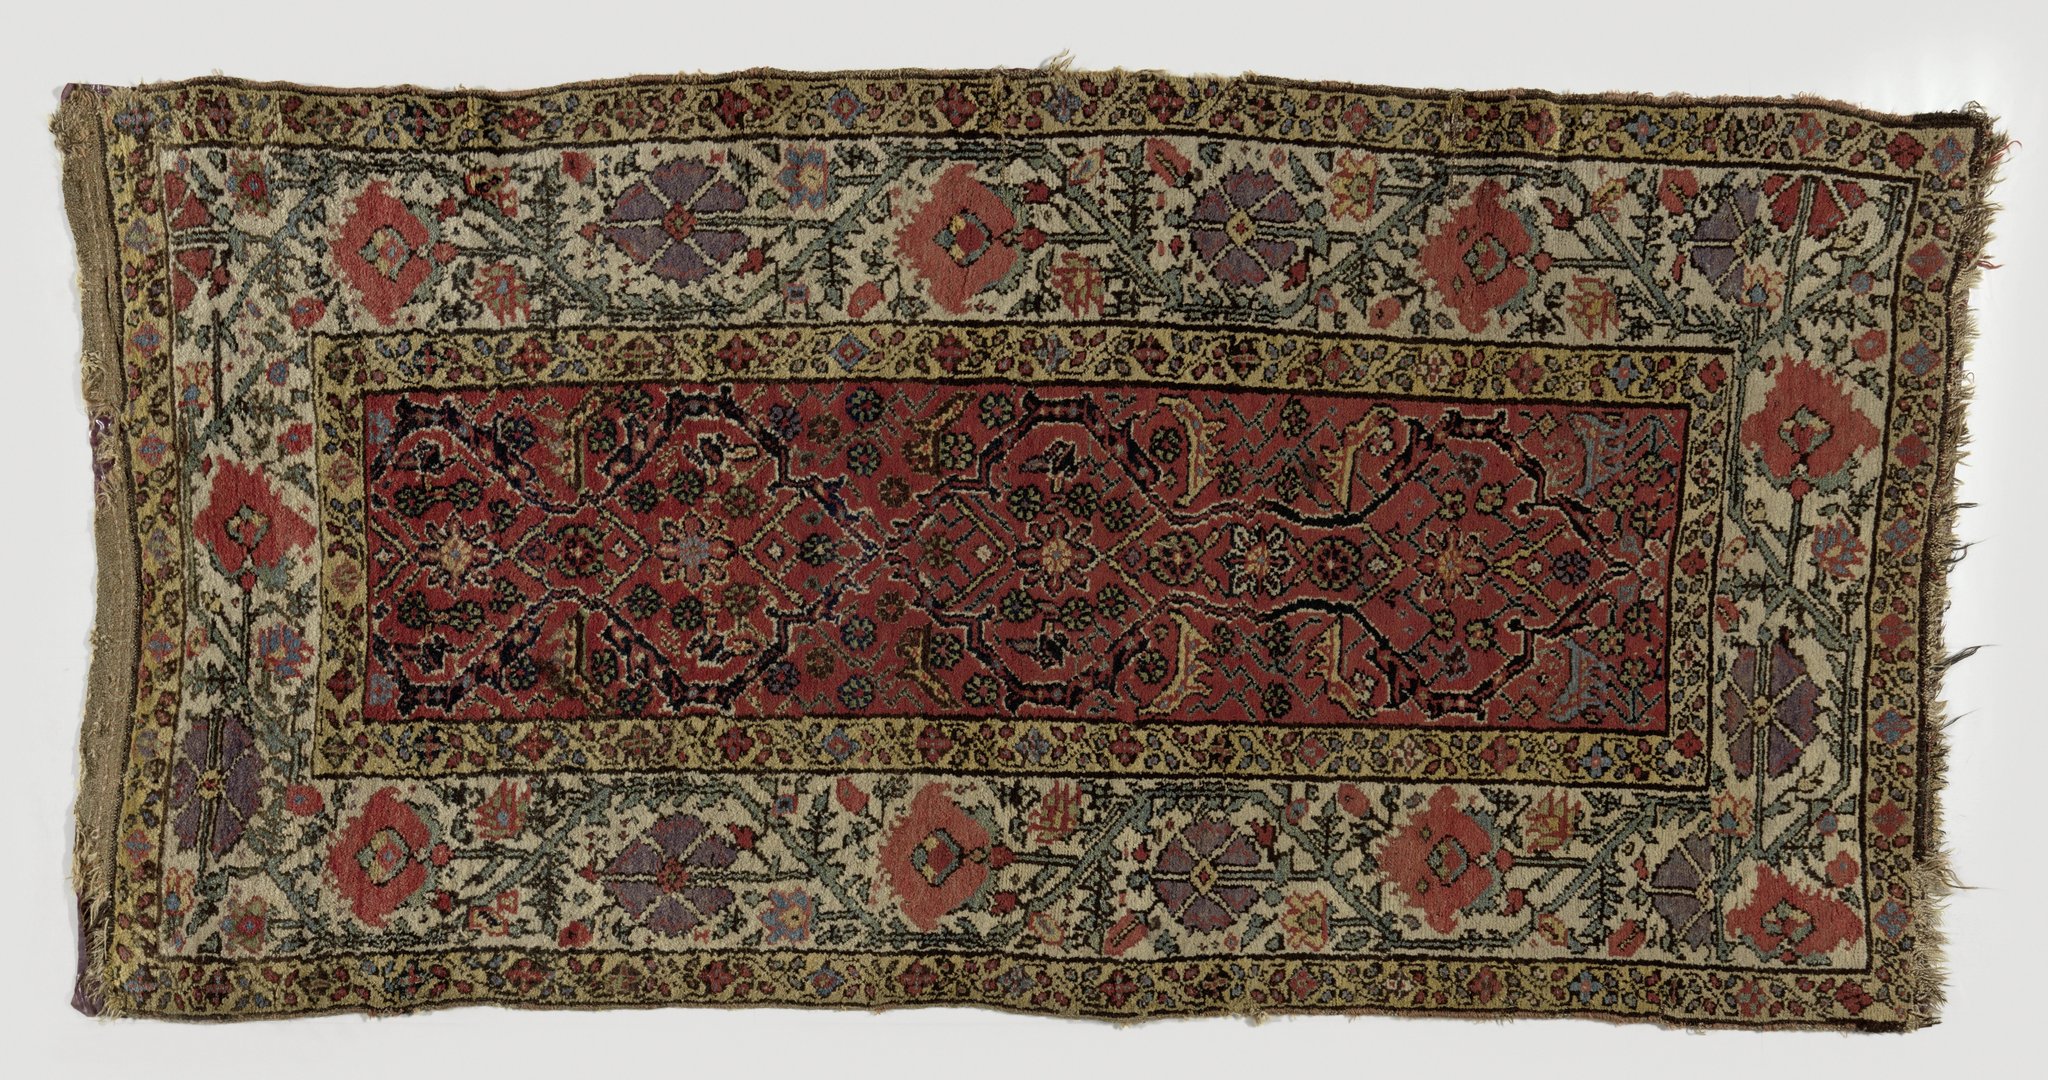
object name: oriental rug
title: Oosters tapijt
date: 1800-1900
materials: wool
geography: northwest persia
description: Oosters tapijt, waarvan het middenveld versierd is met arabesken tegen een achtergrond van stijve ranken met bloemen en bladeren. Breedste rand versierd met hoekig lopende rand met rozetbloemen.